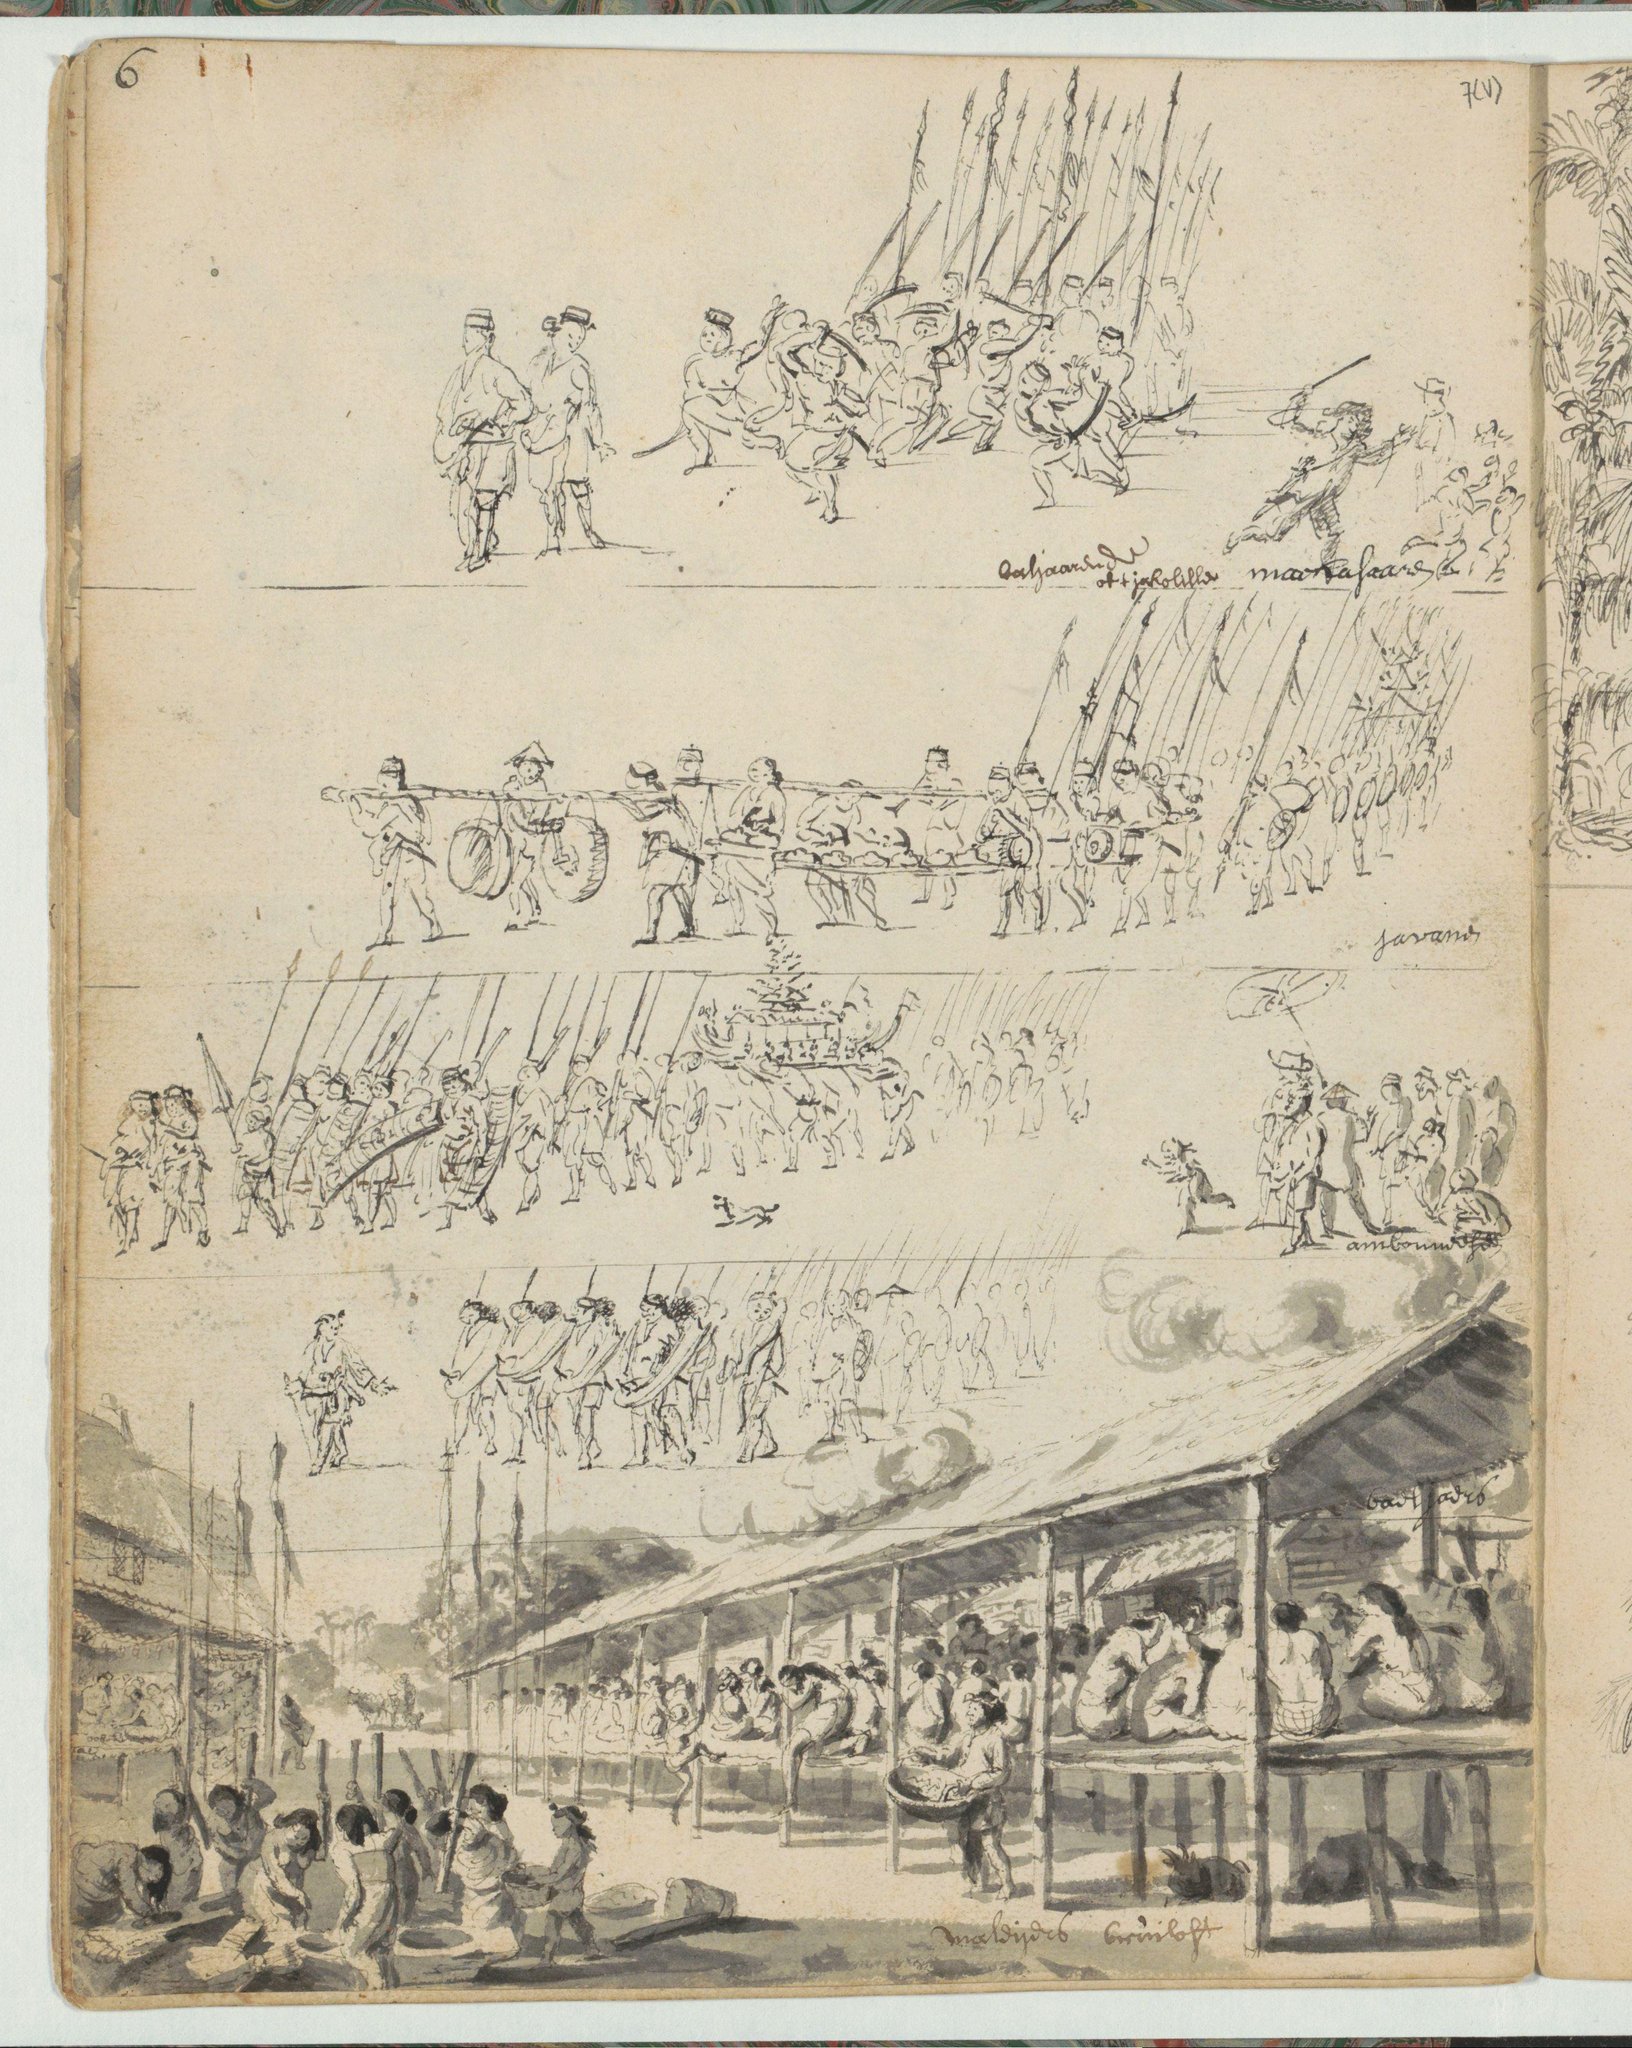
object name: sketchbook leaf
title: Ambonese en Javaanse parades en een Maleier bruiloft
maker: wouter schouten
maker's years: 1638-1704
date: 1664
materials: ink, paper, pencil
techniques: brush, pen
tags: asiatic races and peoples (indonesians), wedding feast, wedding meal, military parade, pageant, java, malaysia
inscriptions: annotation: ‘[...]/ javaans/ ambon[...]/ [...]/ malijer bruiloft’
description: Blad 7 verso van een katern van 10 bladen afkomstig uit een schetsboek.